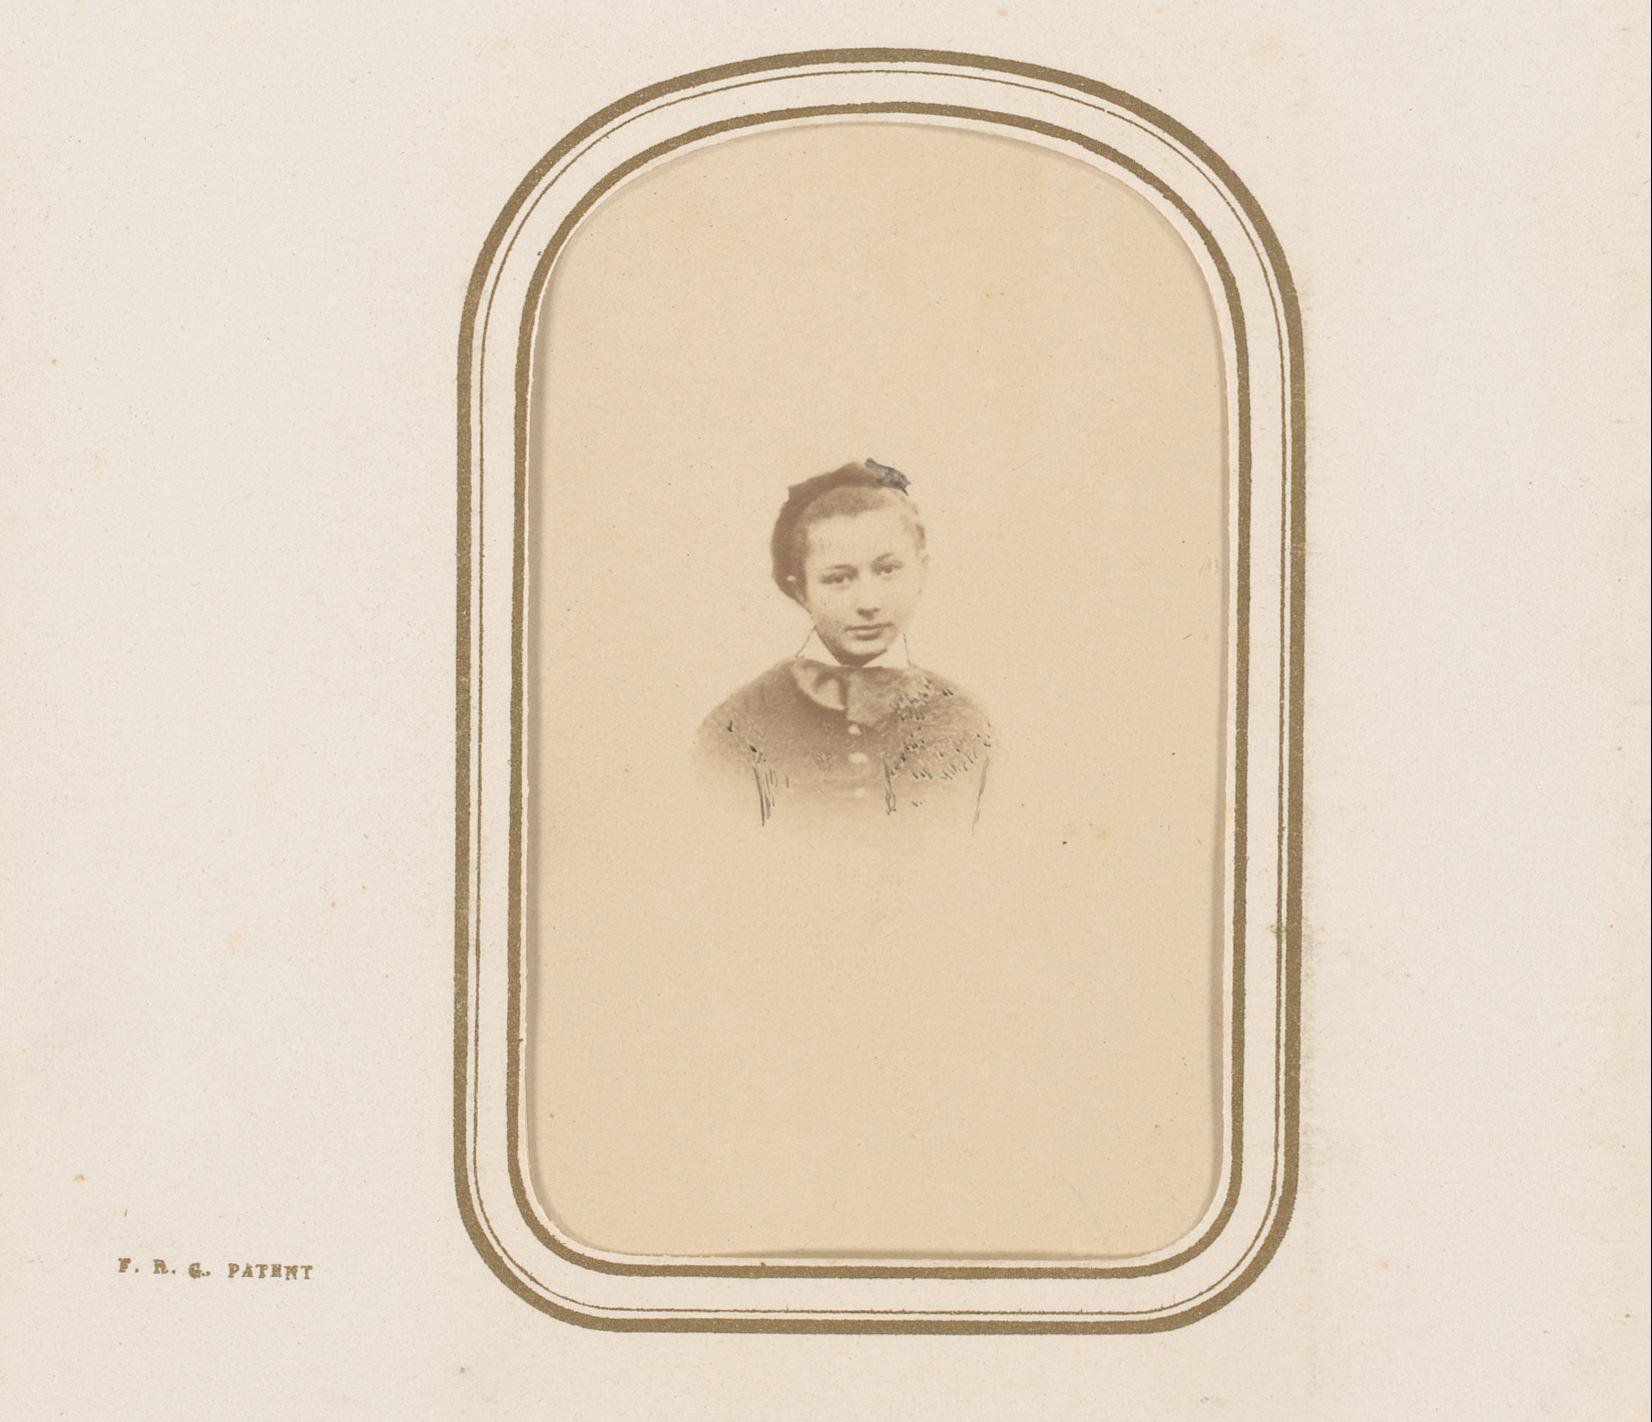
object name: album leaf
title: Portret van een meisje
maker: Anonymous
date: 1876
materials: cardboard, photographic support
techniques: albumen print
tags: historical persons, girl (child between toddler and youth)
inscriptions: annotation: ‘Jeanne [...]/ [...]/ 14 [...]/ [...] 17 novembre/ 1876/ [...]’